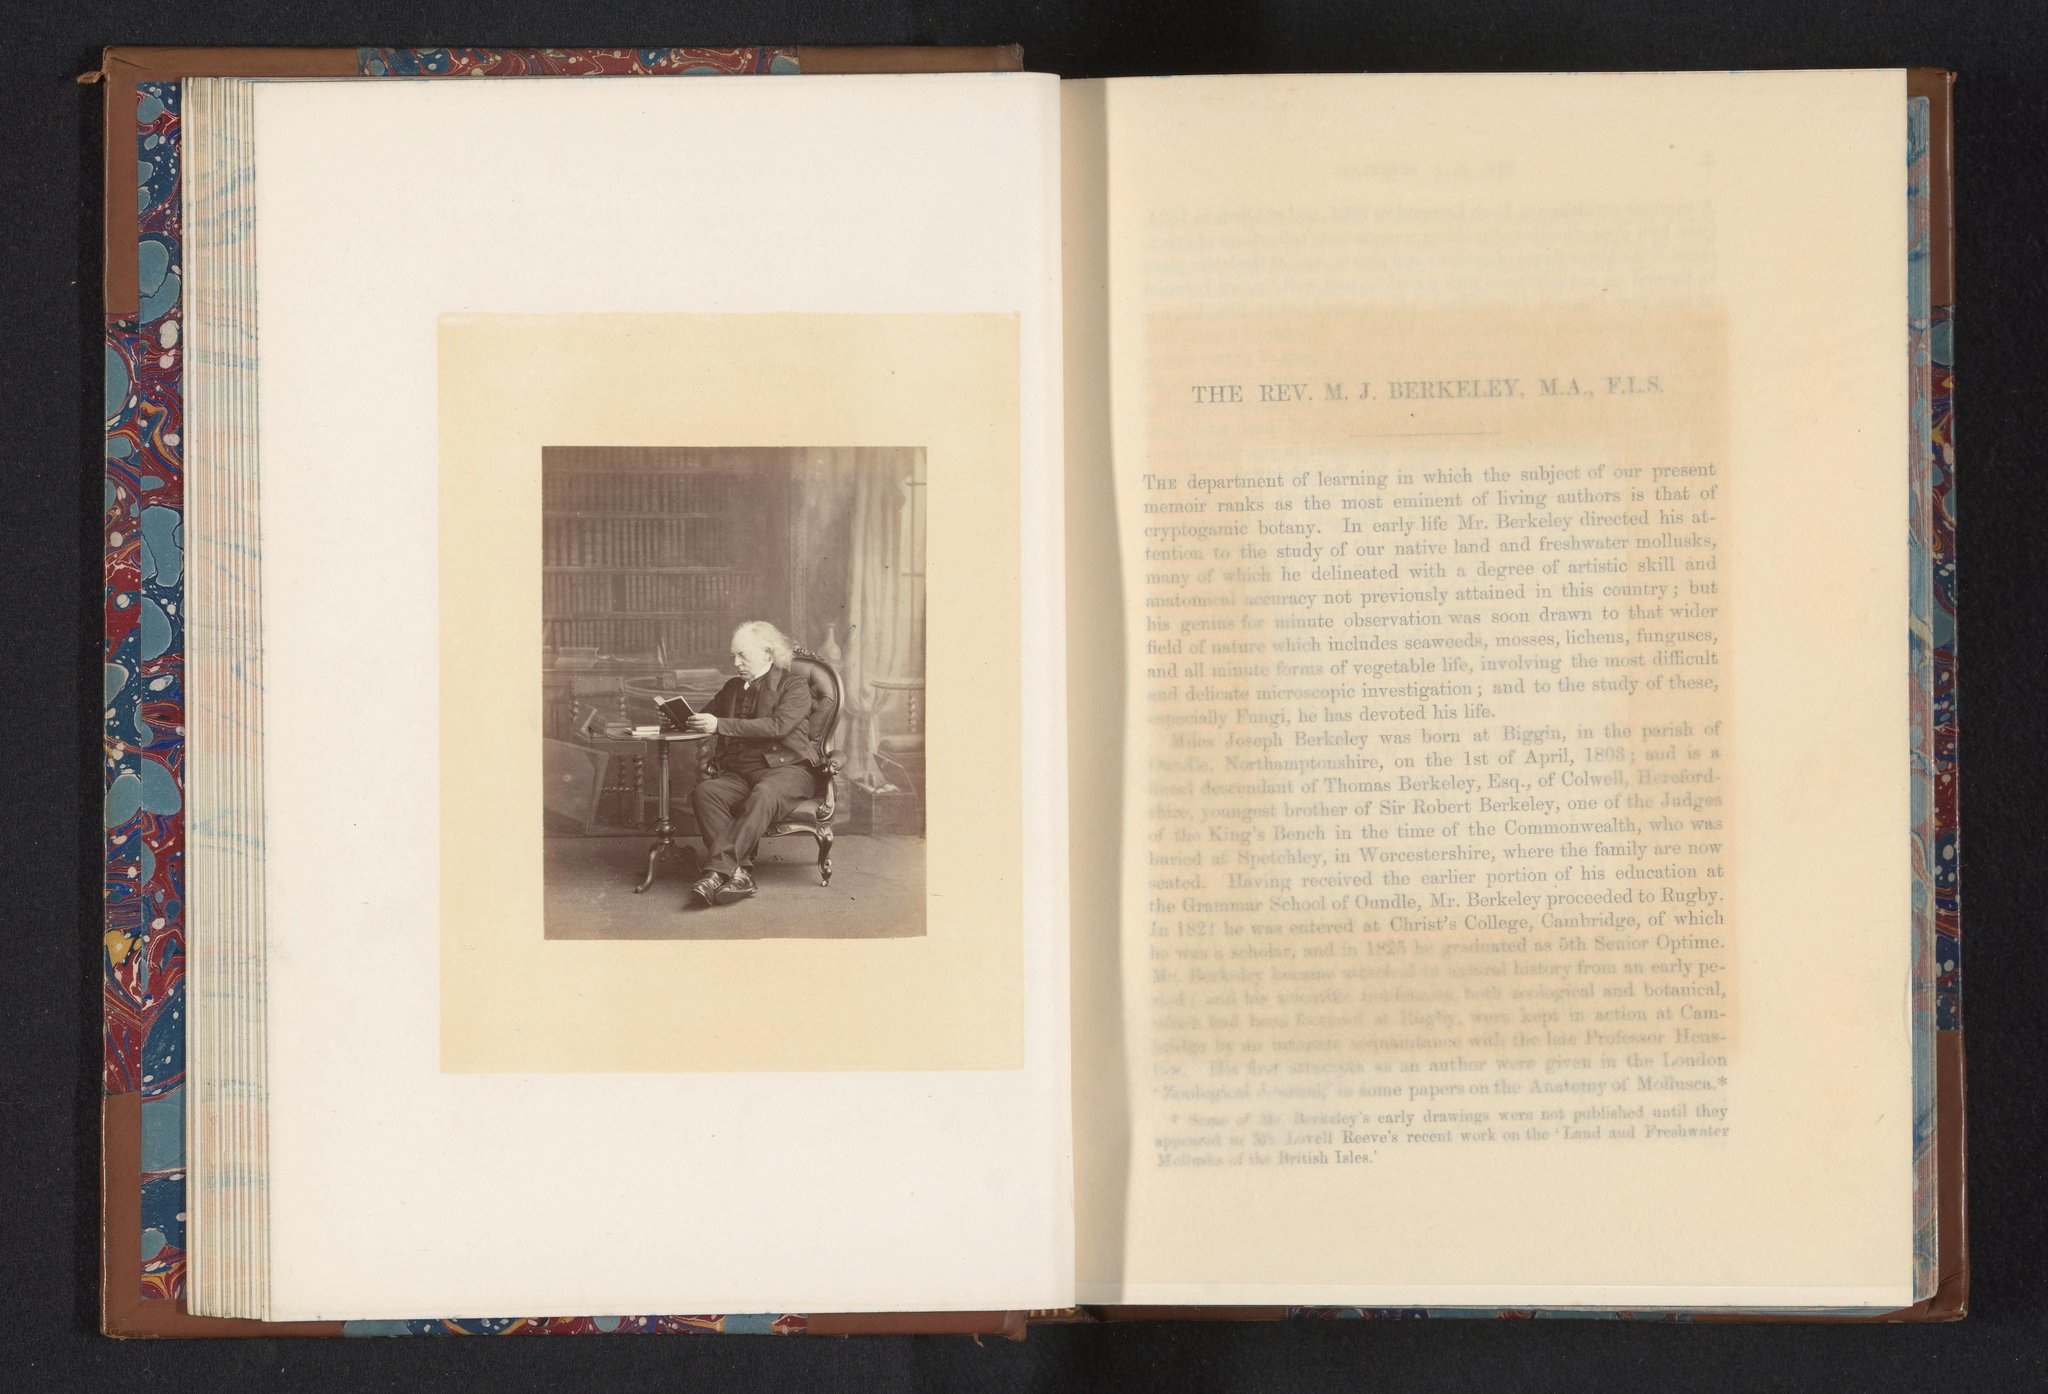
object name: photograph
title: Portret van Miles Joseph Berkeley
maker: ernest edwards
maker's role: fotograaf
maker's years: 1837-1903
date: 1853-1867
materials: photographic support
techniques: albumen print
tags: adult man, historical persons